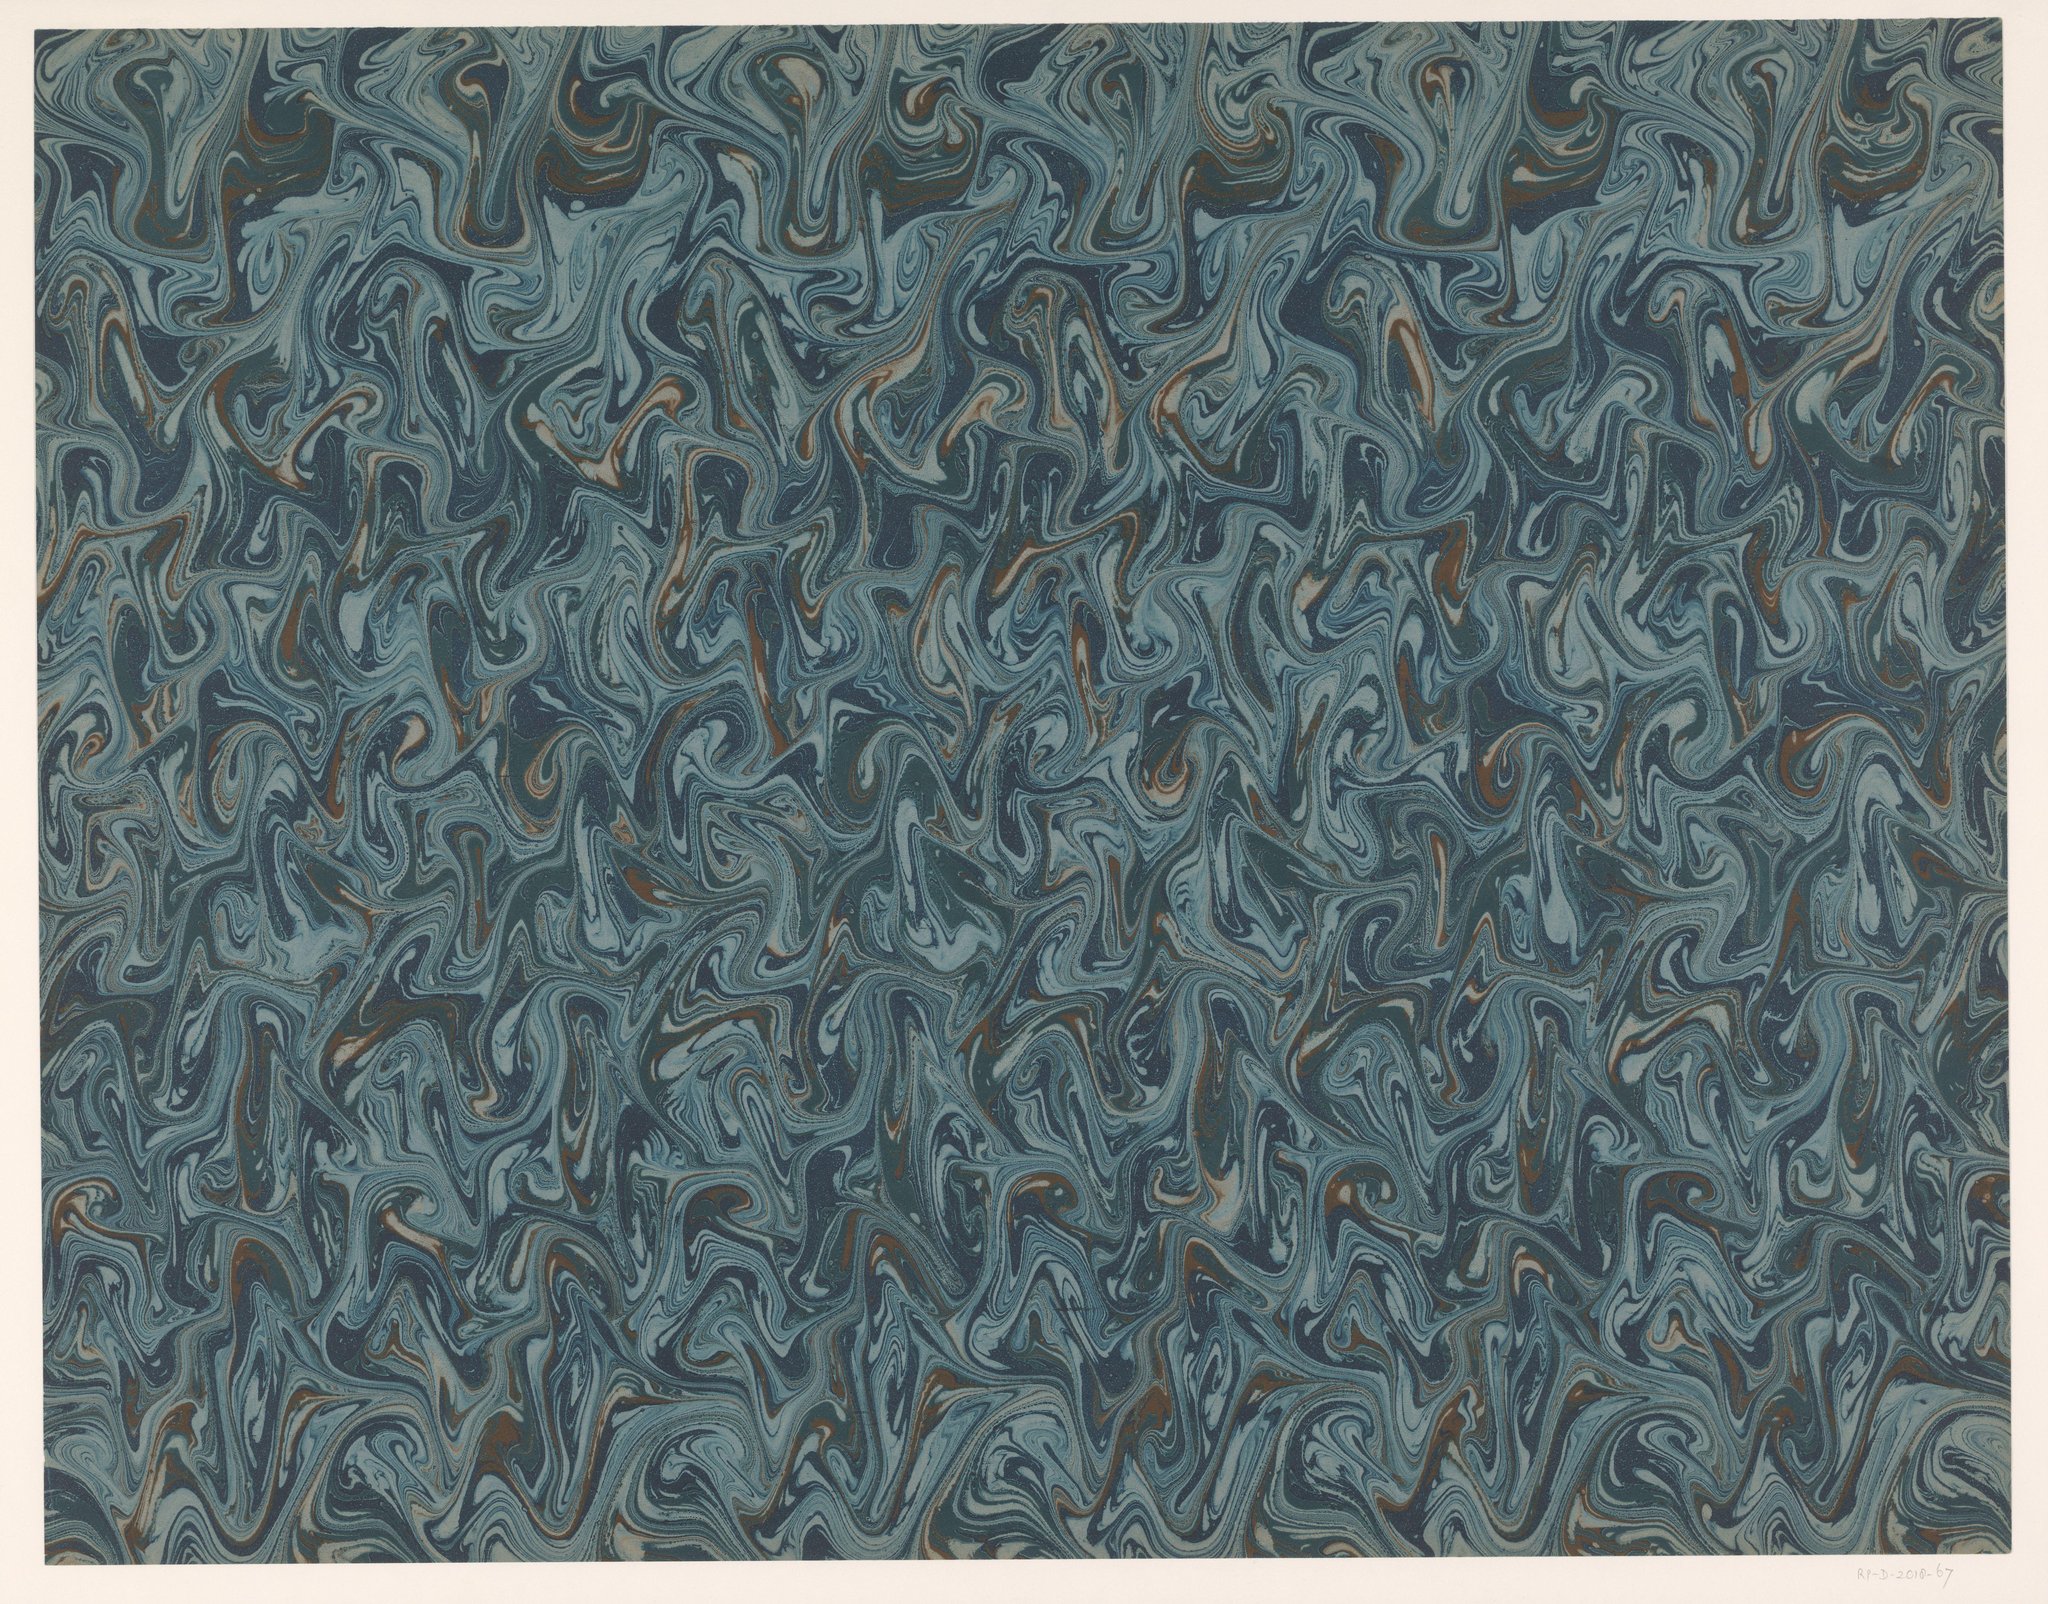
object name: marbled paper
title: Fantasiemarmer in verschillende tinten blauw en bruin op blauw papier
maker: Anonymous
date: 1900-2000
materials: paint, paper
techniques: marbled paper